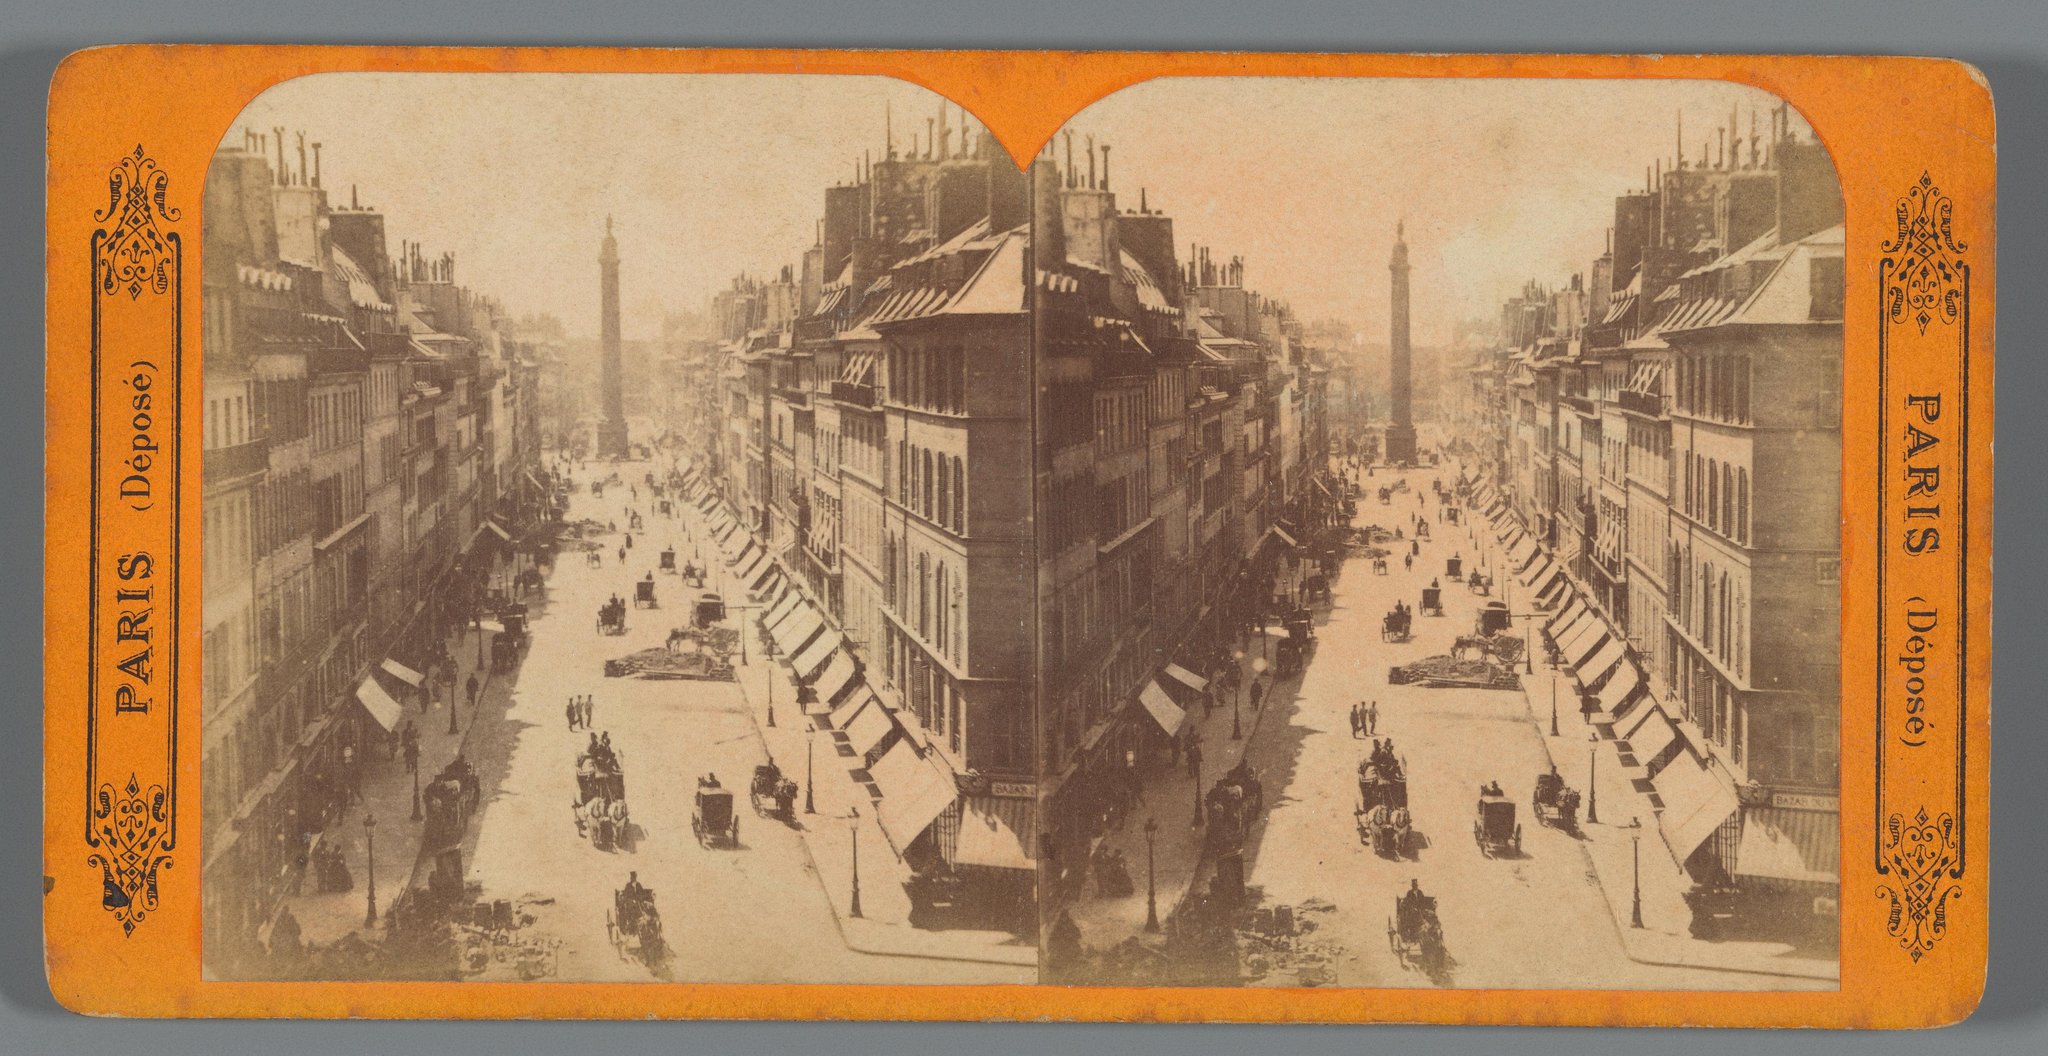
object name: stereograph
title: Gezicht op de Colonne Vendôme, gezien vanaf de rue de Castiglione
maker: Anonymous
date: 1868-1890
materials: cardboard, paper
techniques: albumen print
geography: paris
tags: obelisk, needle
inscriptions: inscription: ‘(Déposé)’